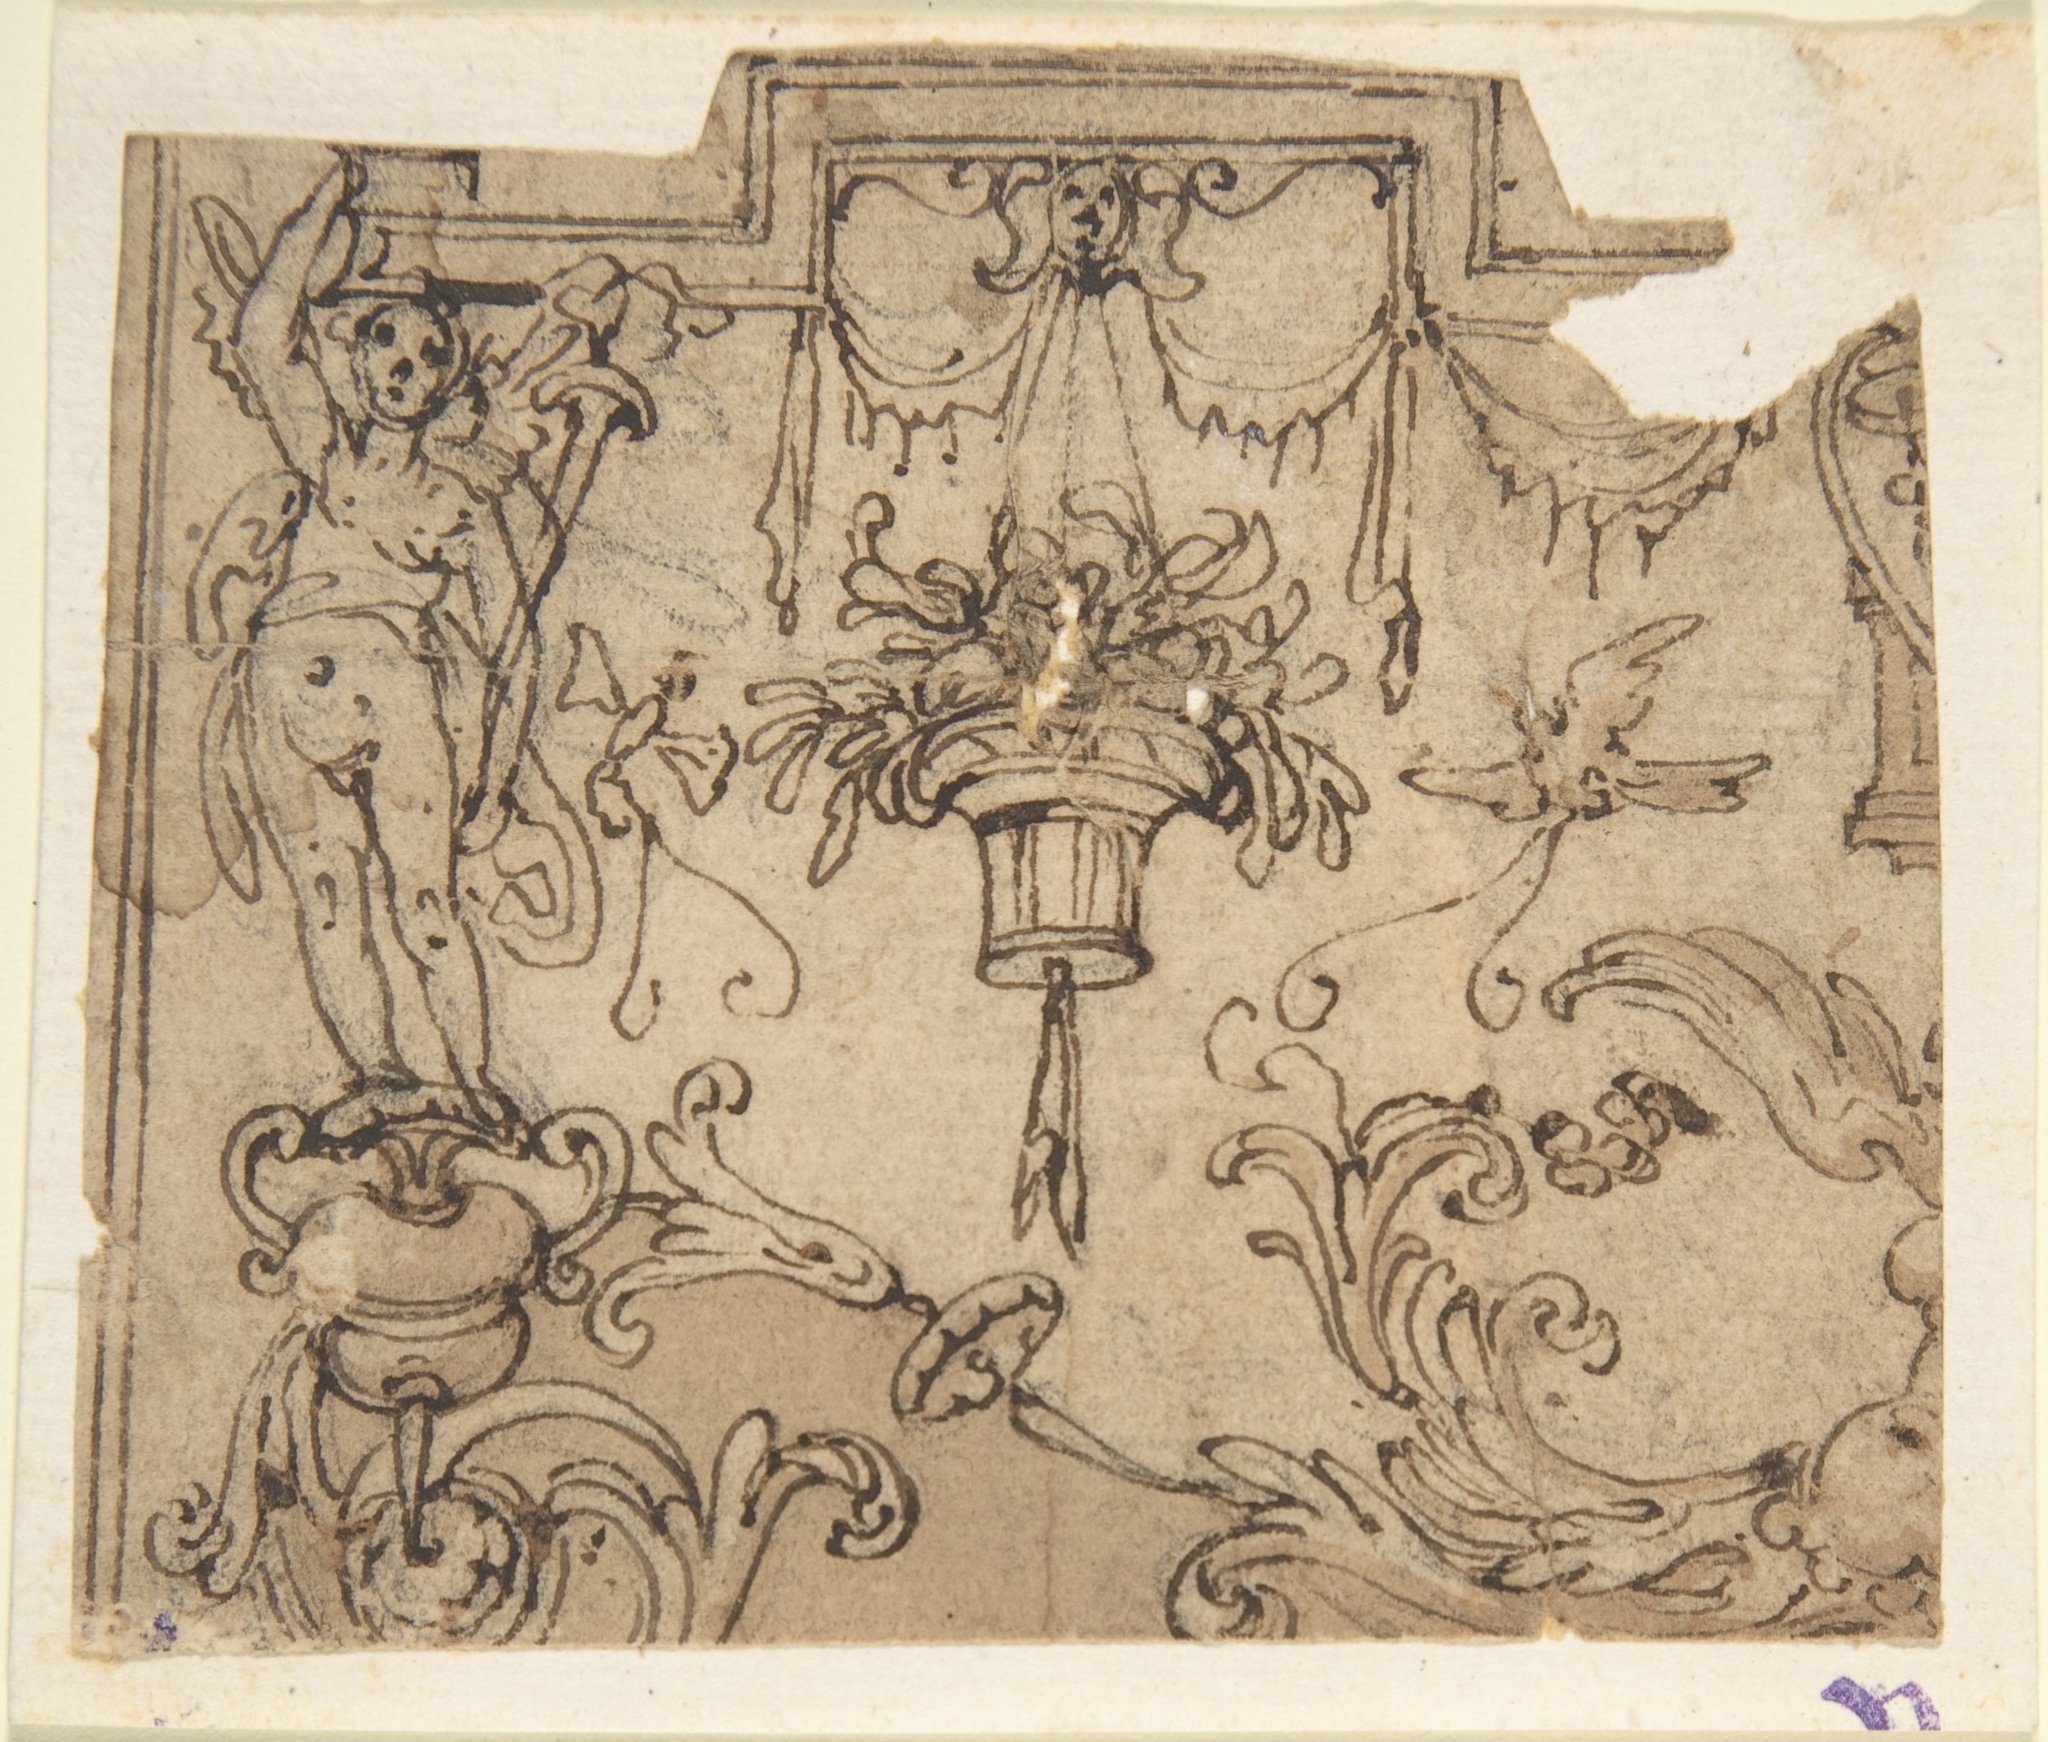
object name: drawing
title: Fragment of a Scheme with Grotesque Decorations (recto); Fragment of an Ornament Design after the Antique (verso)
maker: anonymous, italian?, 16th century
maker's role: artist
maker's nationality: italian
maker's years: 1500-1600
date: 1501-1600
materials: charcoal, ink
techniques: brush, pen, wash